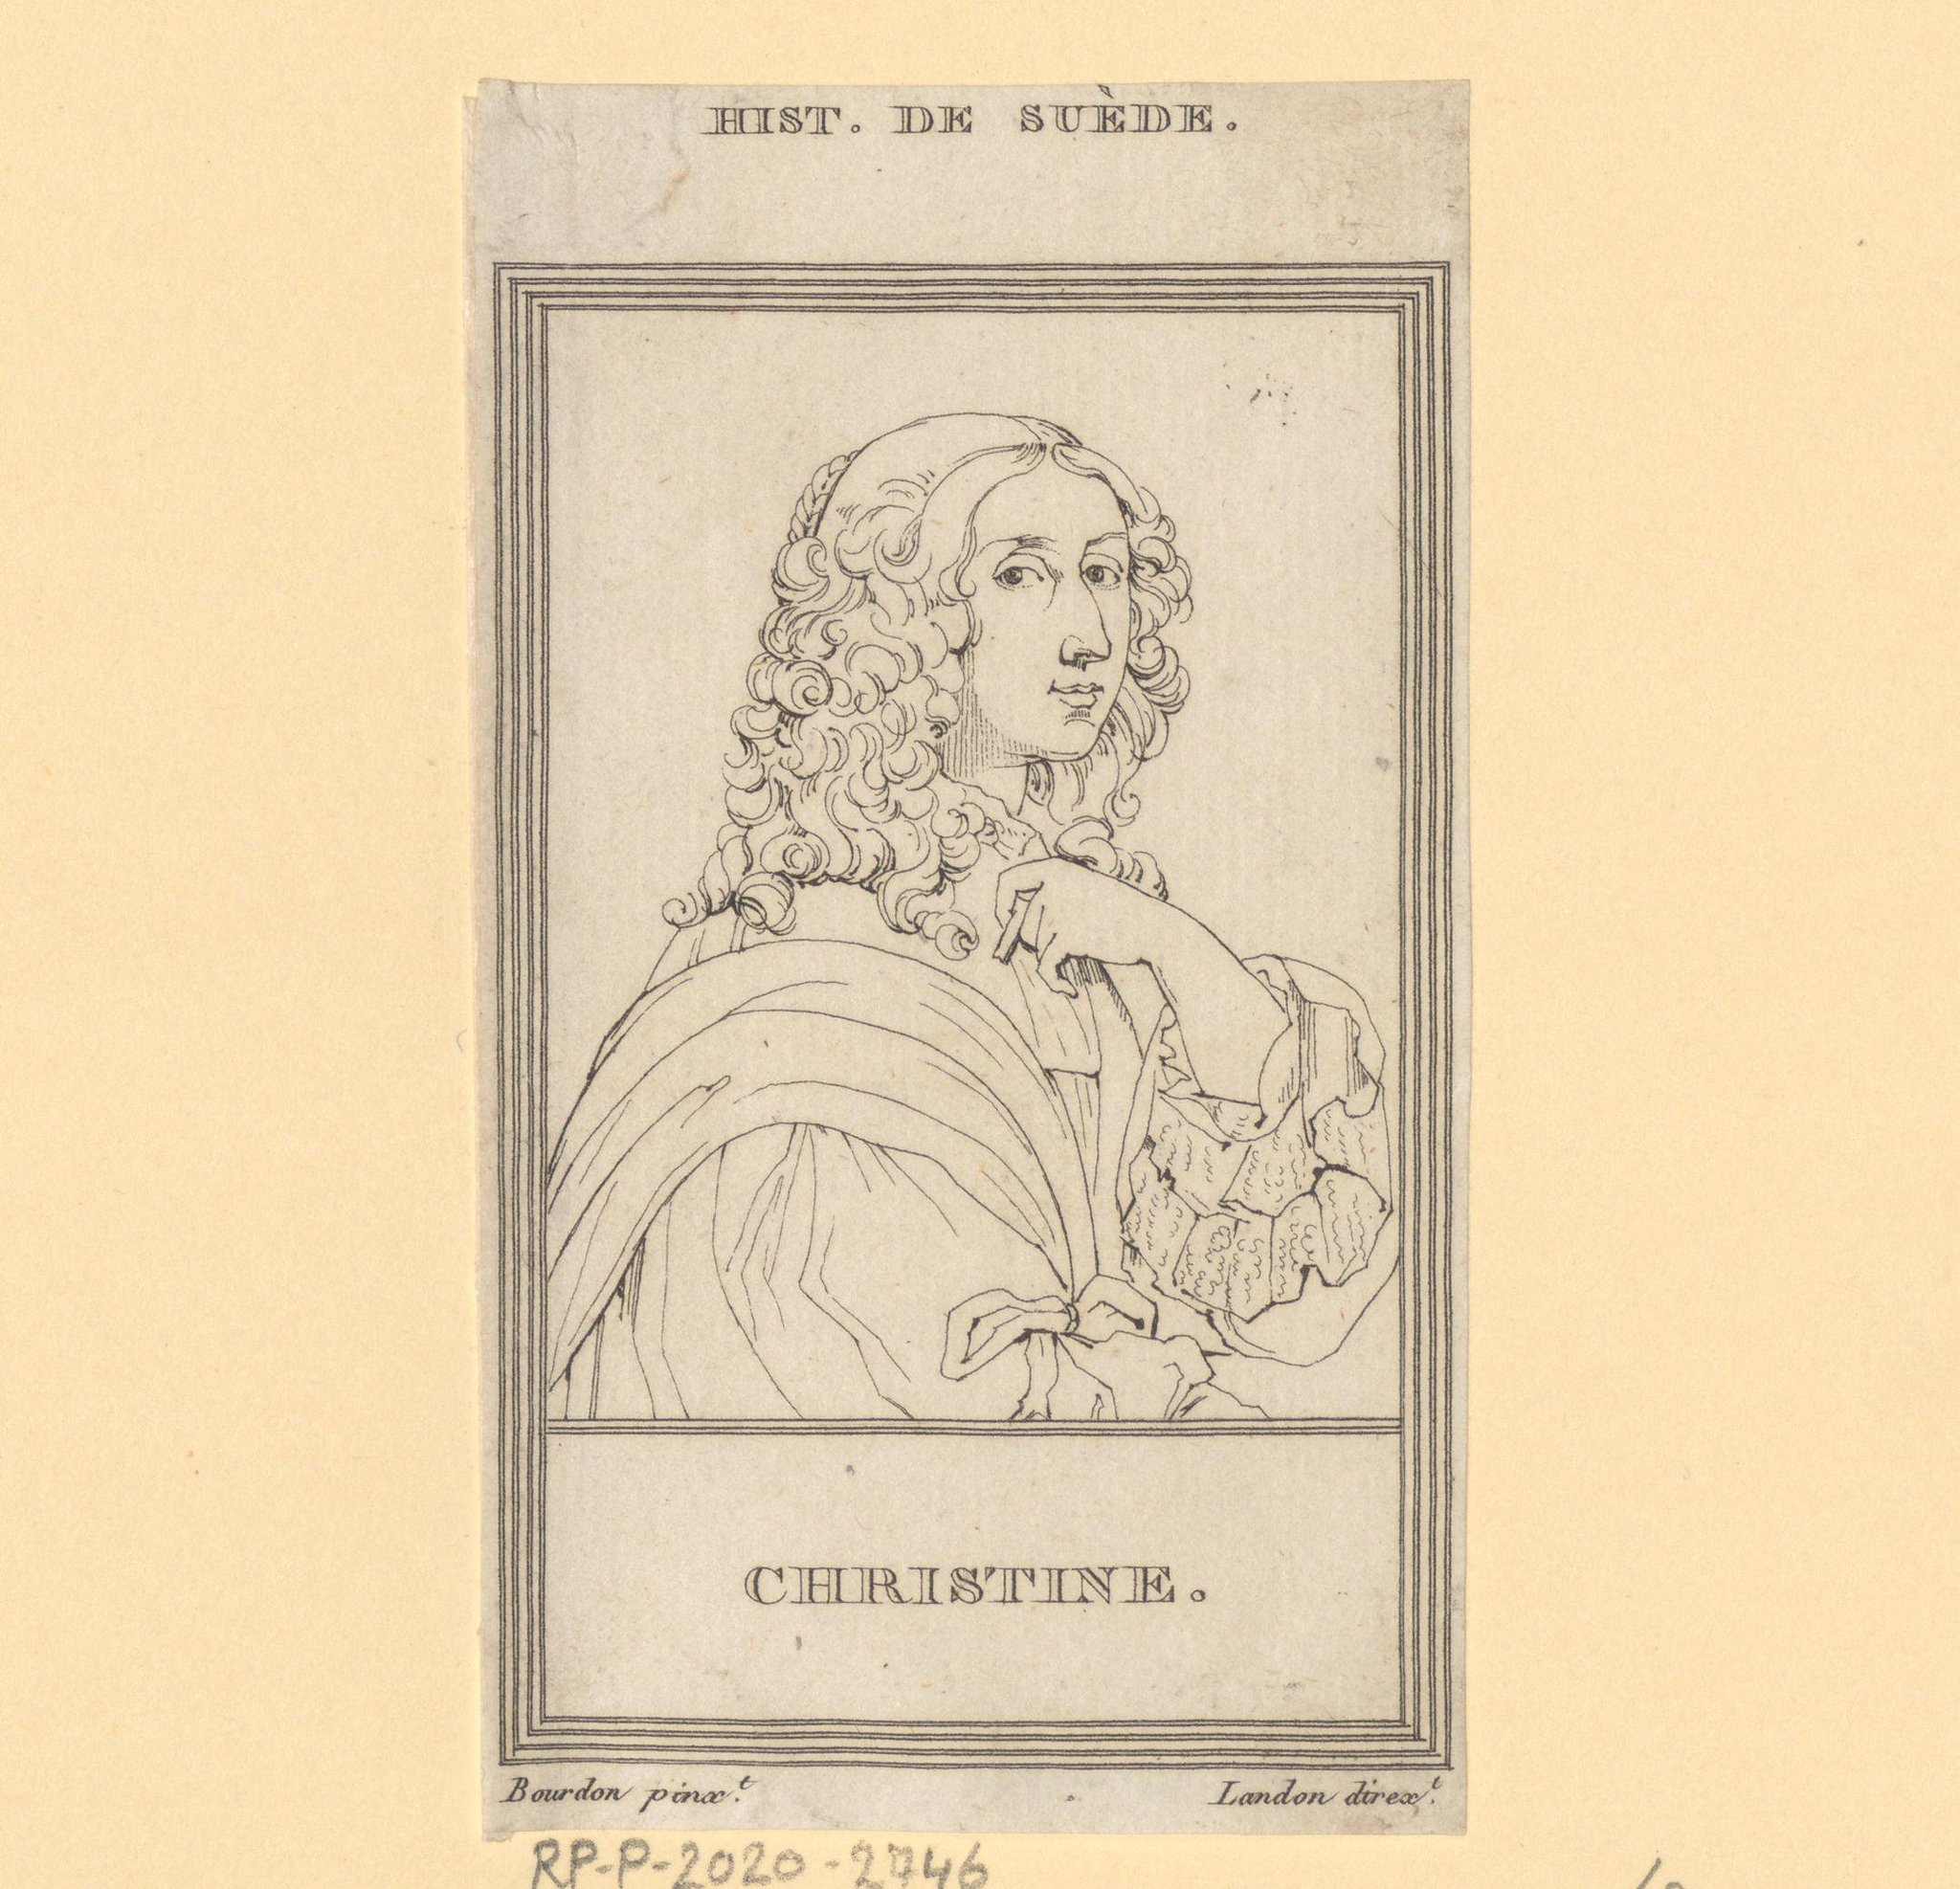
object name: print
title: Portret van Christina, koningin van Zweden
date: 1805-1811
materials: paper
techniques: engraving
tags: rome, christina (koningin van zweden), historical persons - bb - woman, queen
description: Prent waarschijnlijk uit: Galerie historique des hommes les plus célèbres (...). Parijs: Charles Paul Landon, 1805-1811.